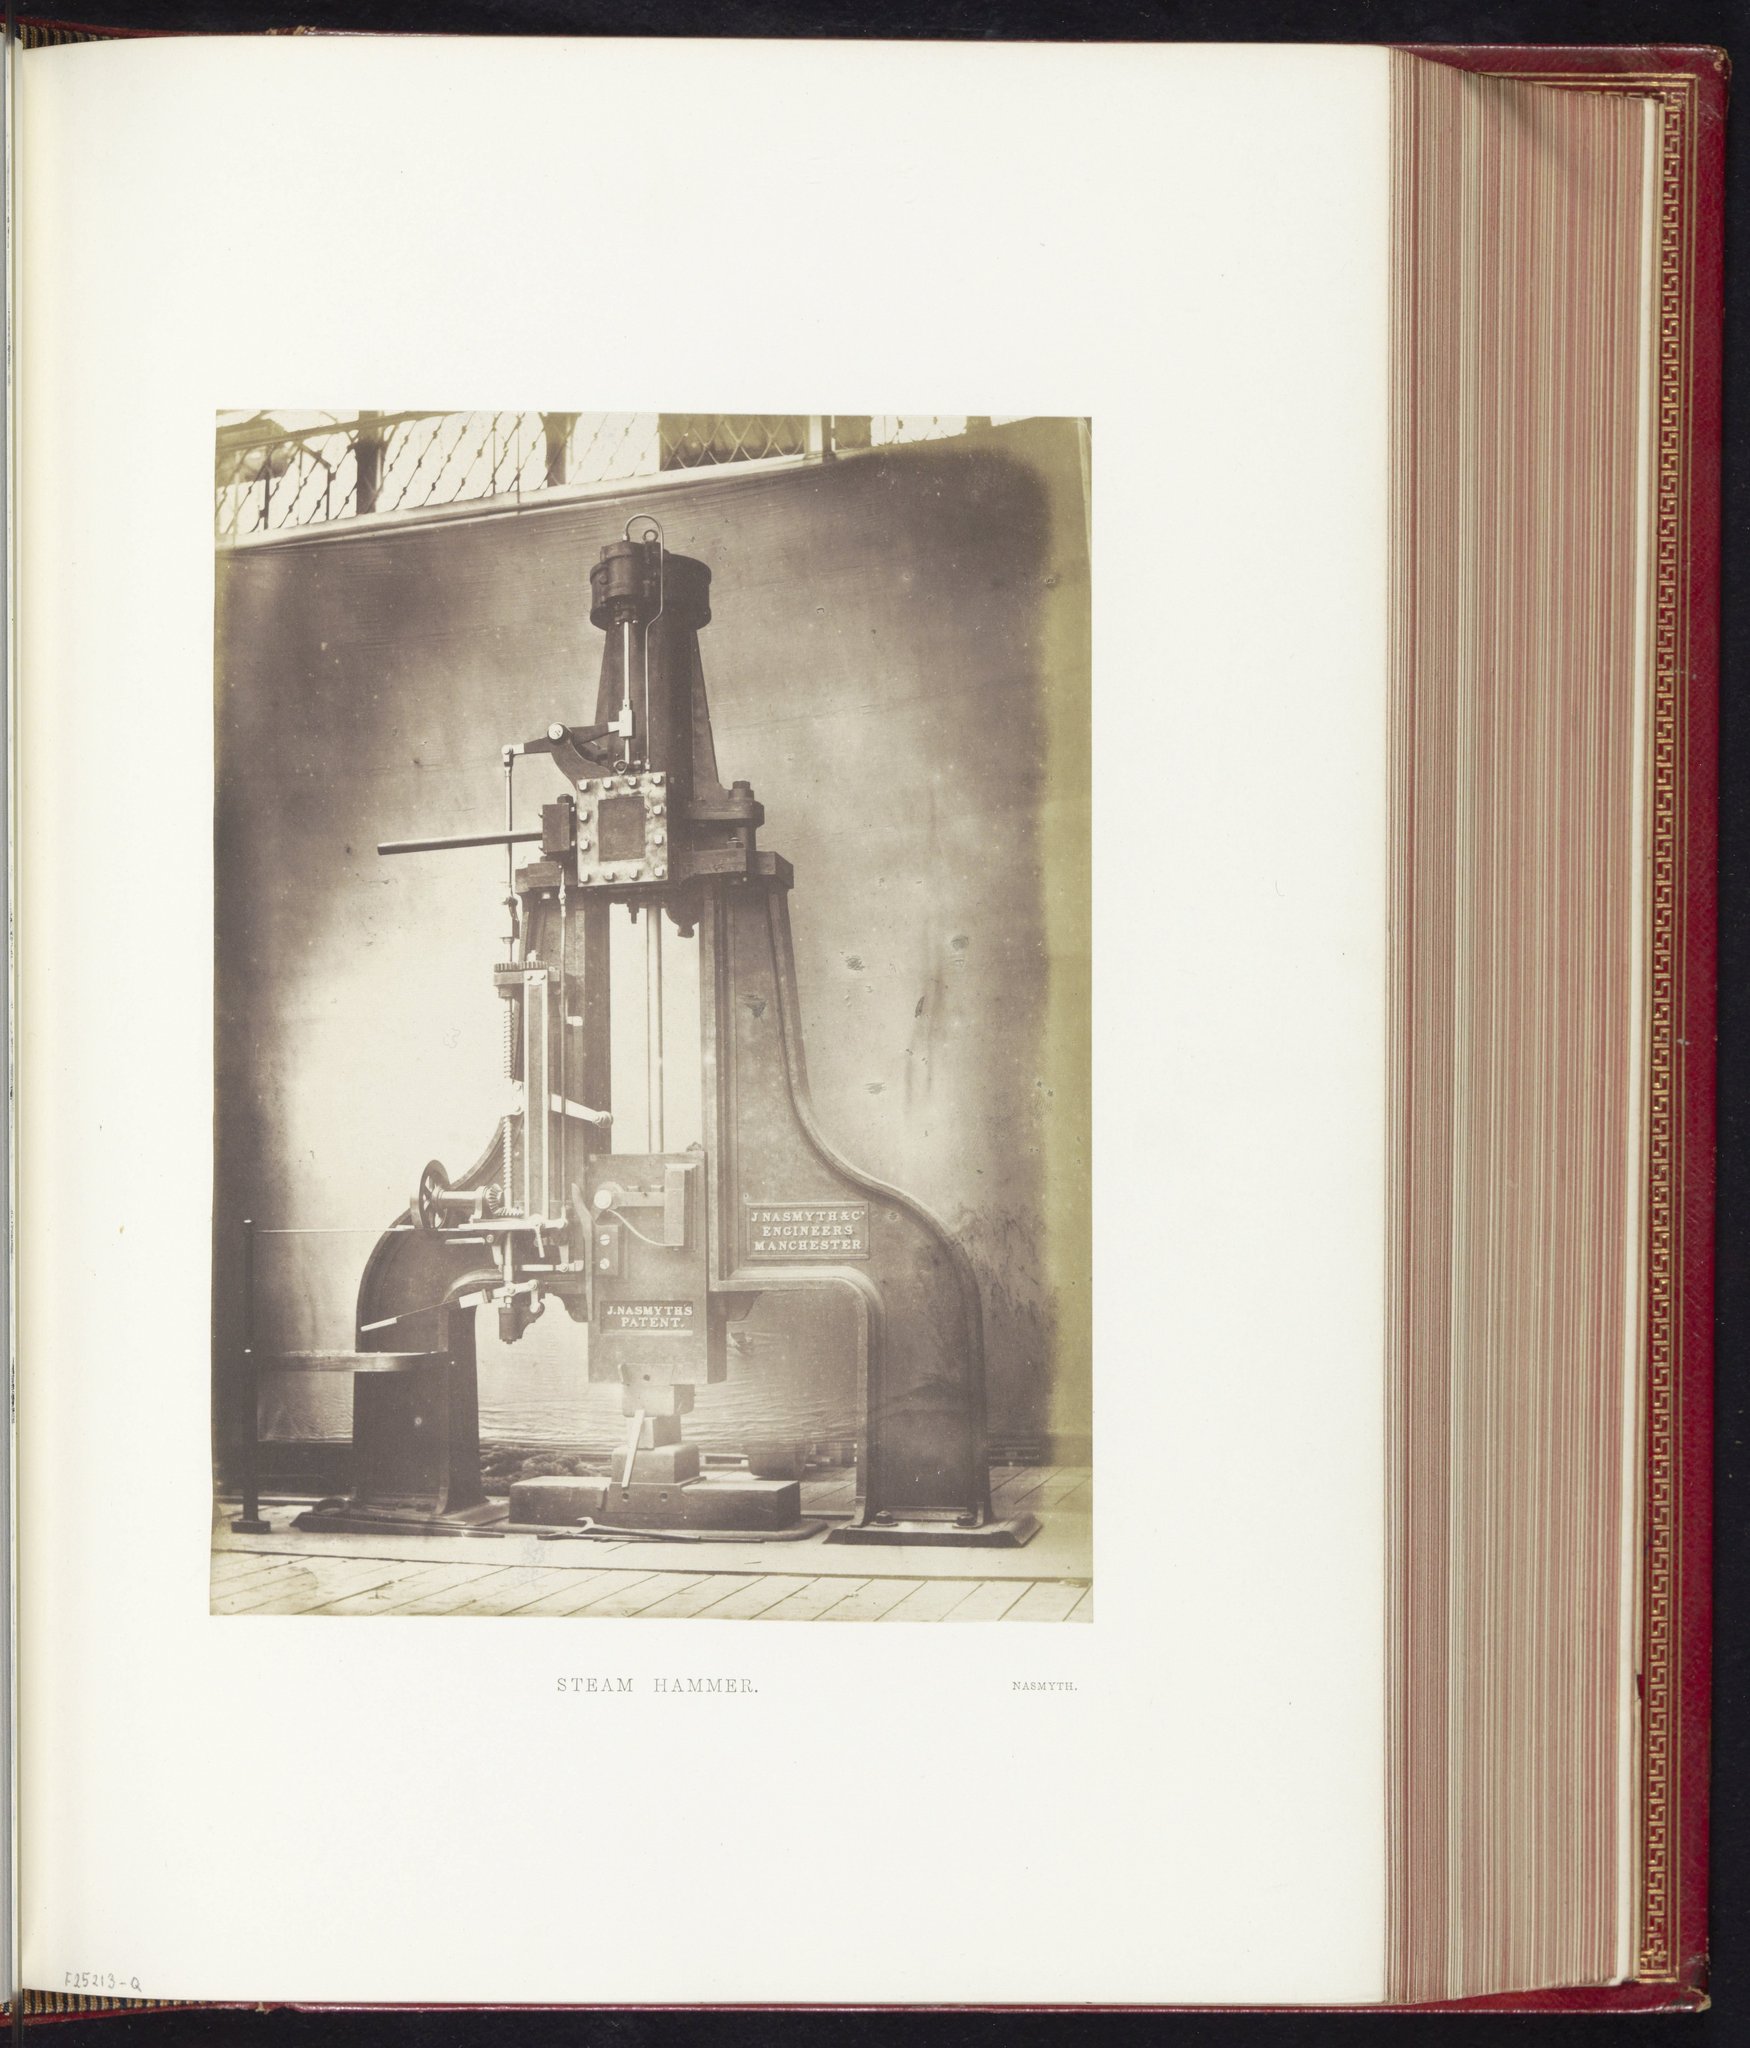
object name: photograph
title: Stoomhamer van Nasmyth op de Great Exhibition of the Works of Industry of All Nations van 1851 in het Crystal Palace in Londen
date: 1851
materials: photographic support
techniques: salted paper print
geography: london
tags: tools, aids, implements ~ crafts and industries: hammer, london